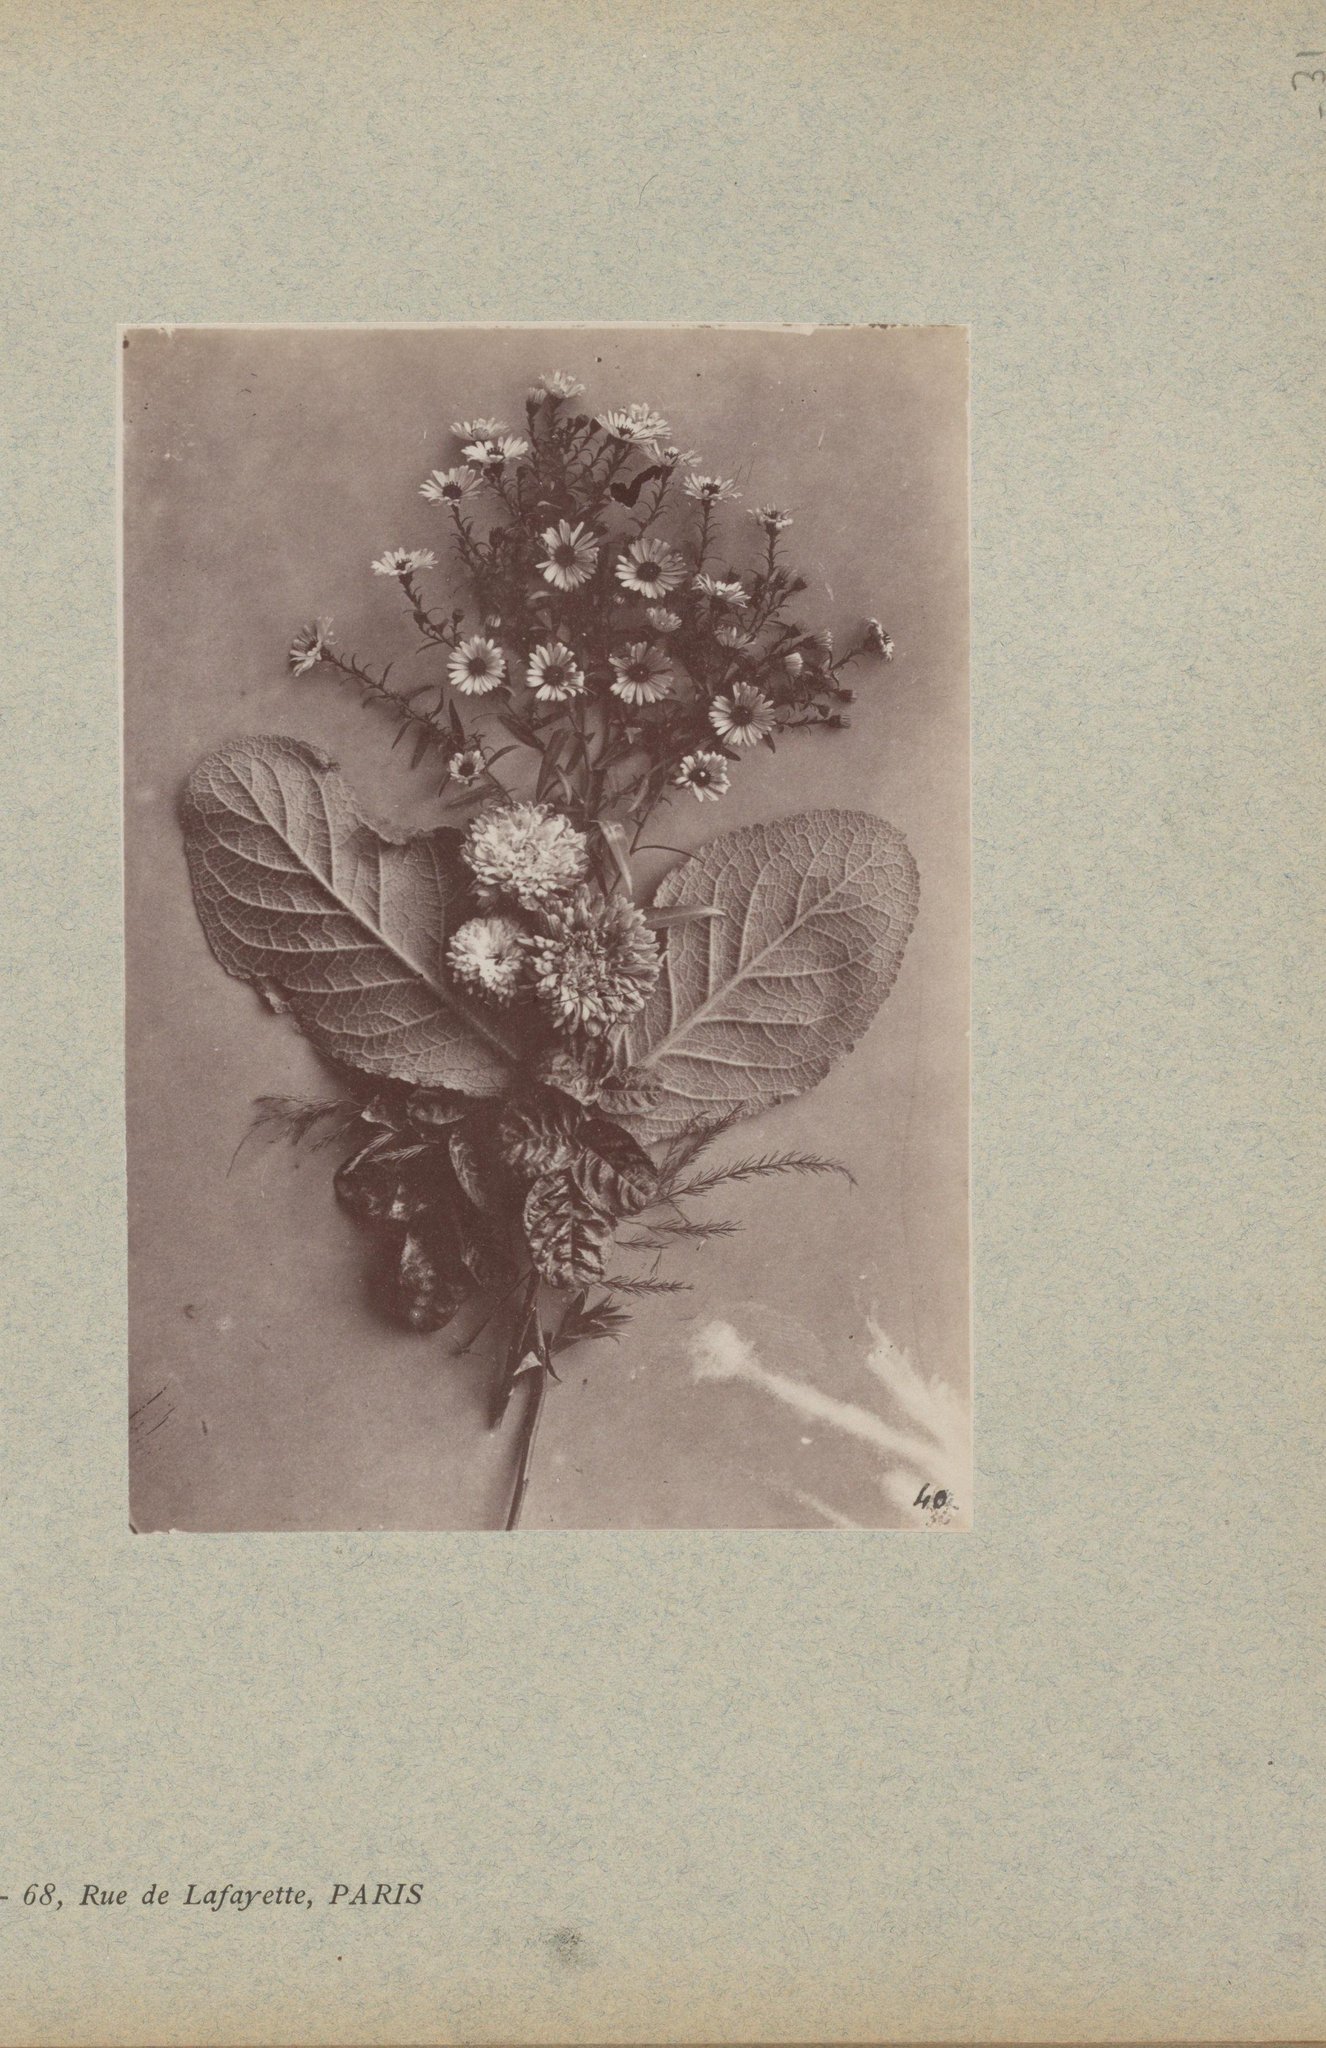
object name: photograph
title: Bloemstudie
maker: a. calavas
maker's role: publisher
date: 1875-1895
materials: cardboard, photographic support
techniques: albumen print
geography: paris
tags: flowers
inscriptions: number: ‘40’, collector's mark: Lugt 3937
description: Onderdeel van Verzamelband met foto's van bloemstudies.